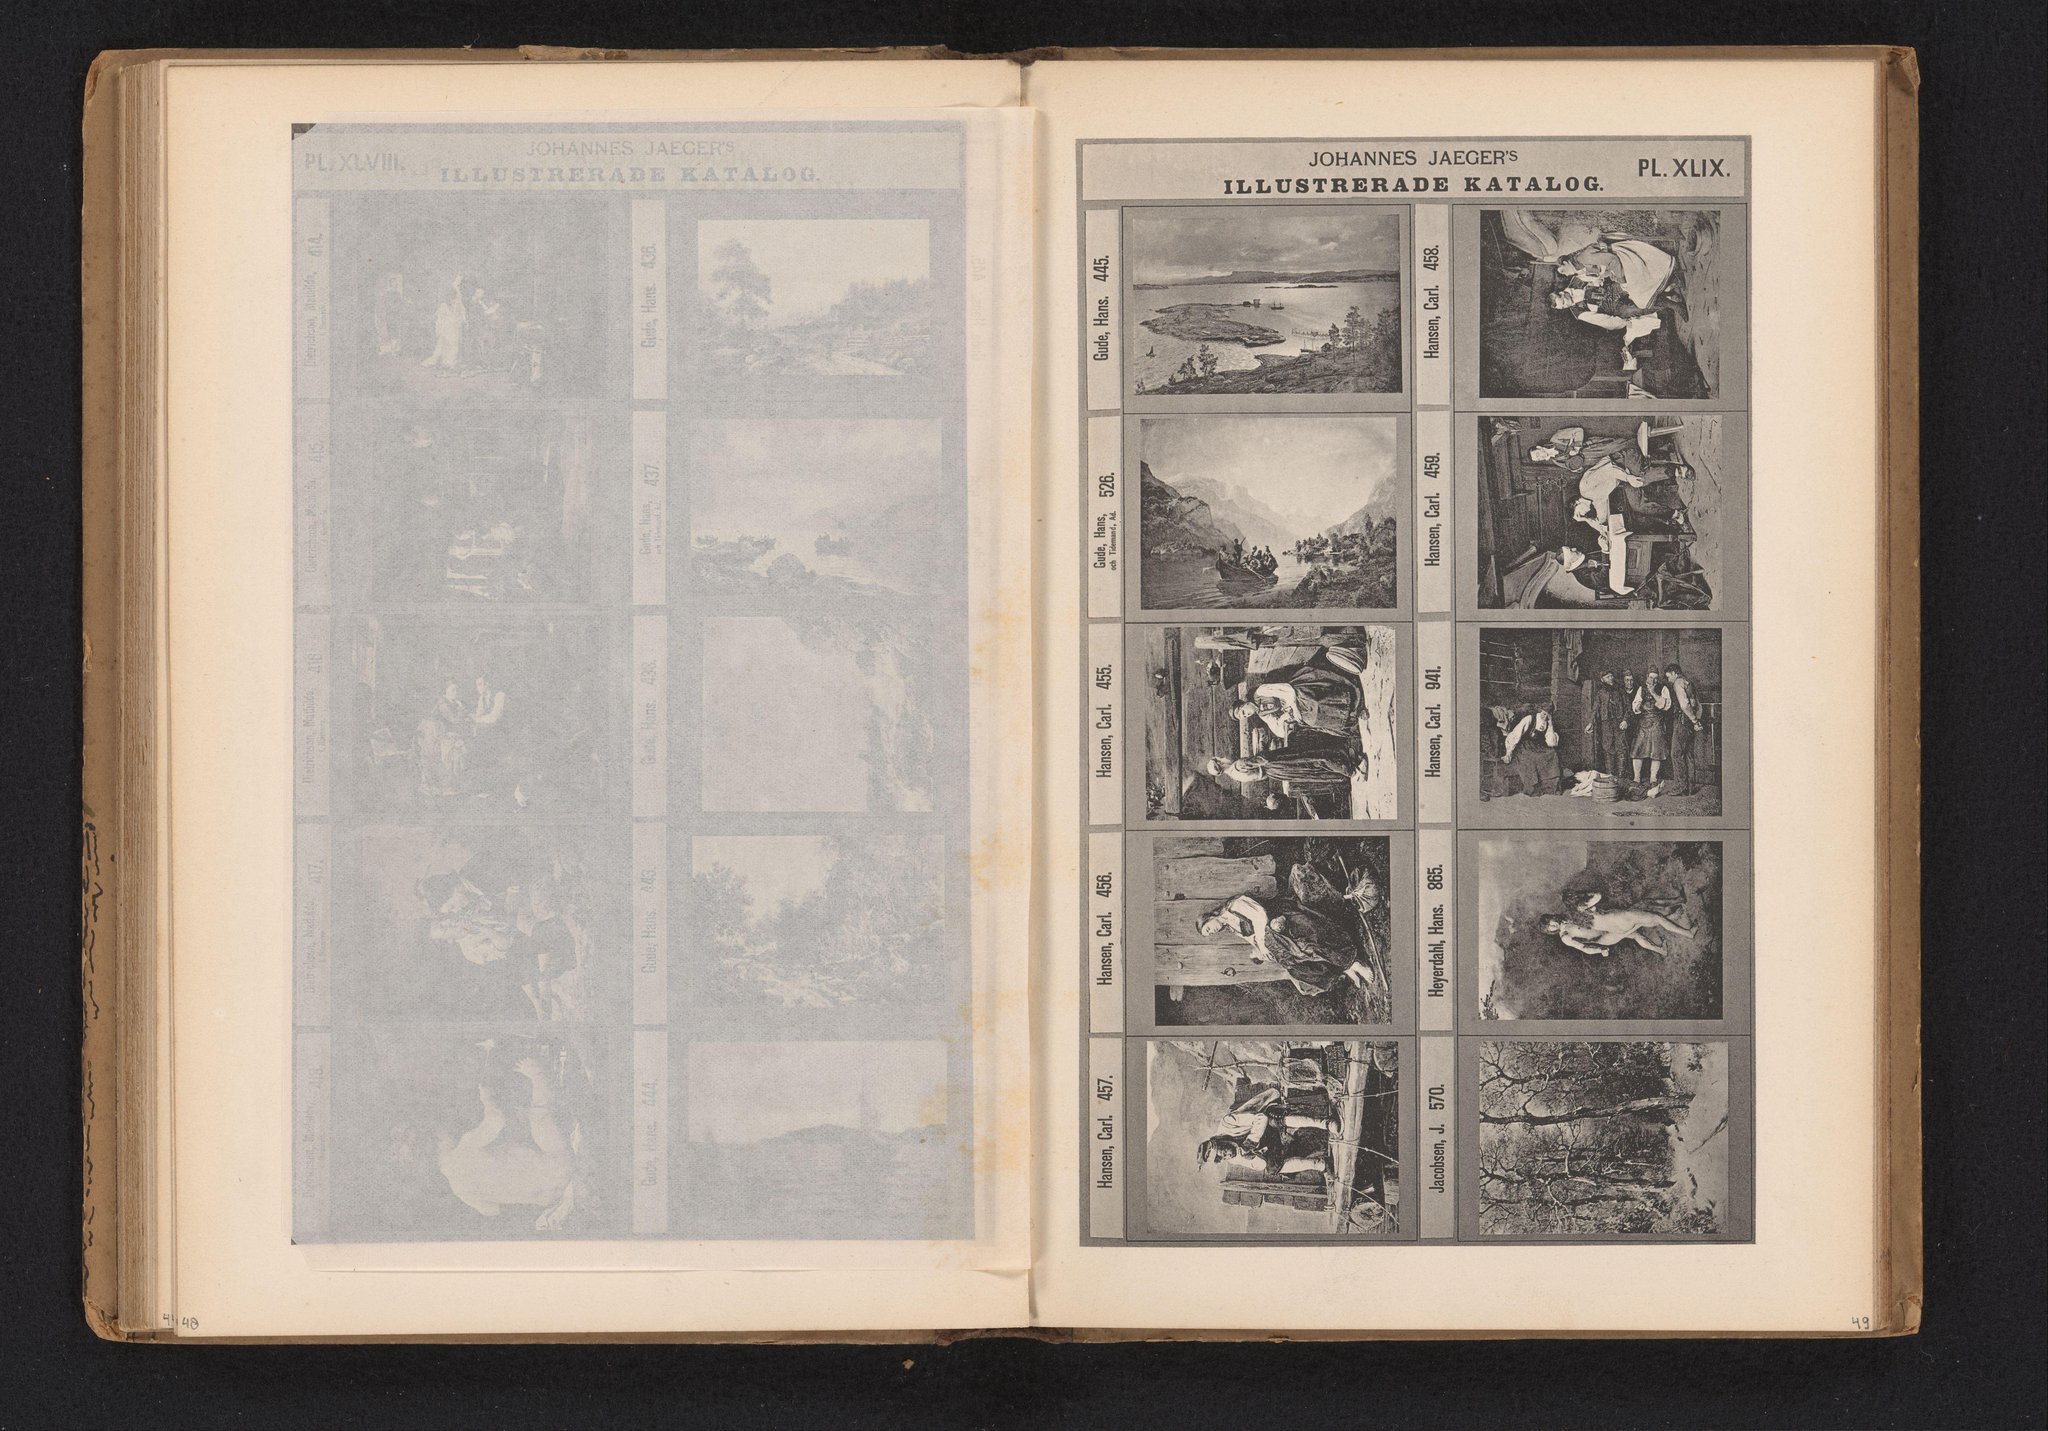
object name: page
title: Johannes Jaeger's Illustrerade Katalog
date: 1872-1882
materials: paper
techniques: photograph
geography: stockholm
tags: picture, painting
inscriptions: number: ‘PL. XLIX.’